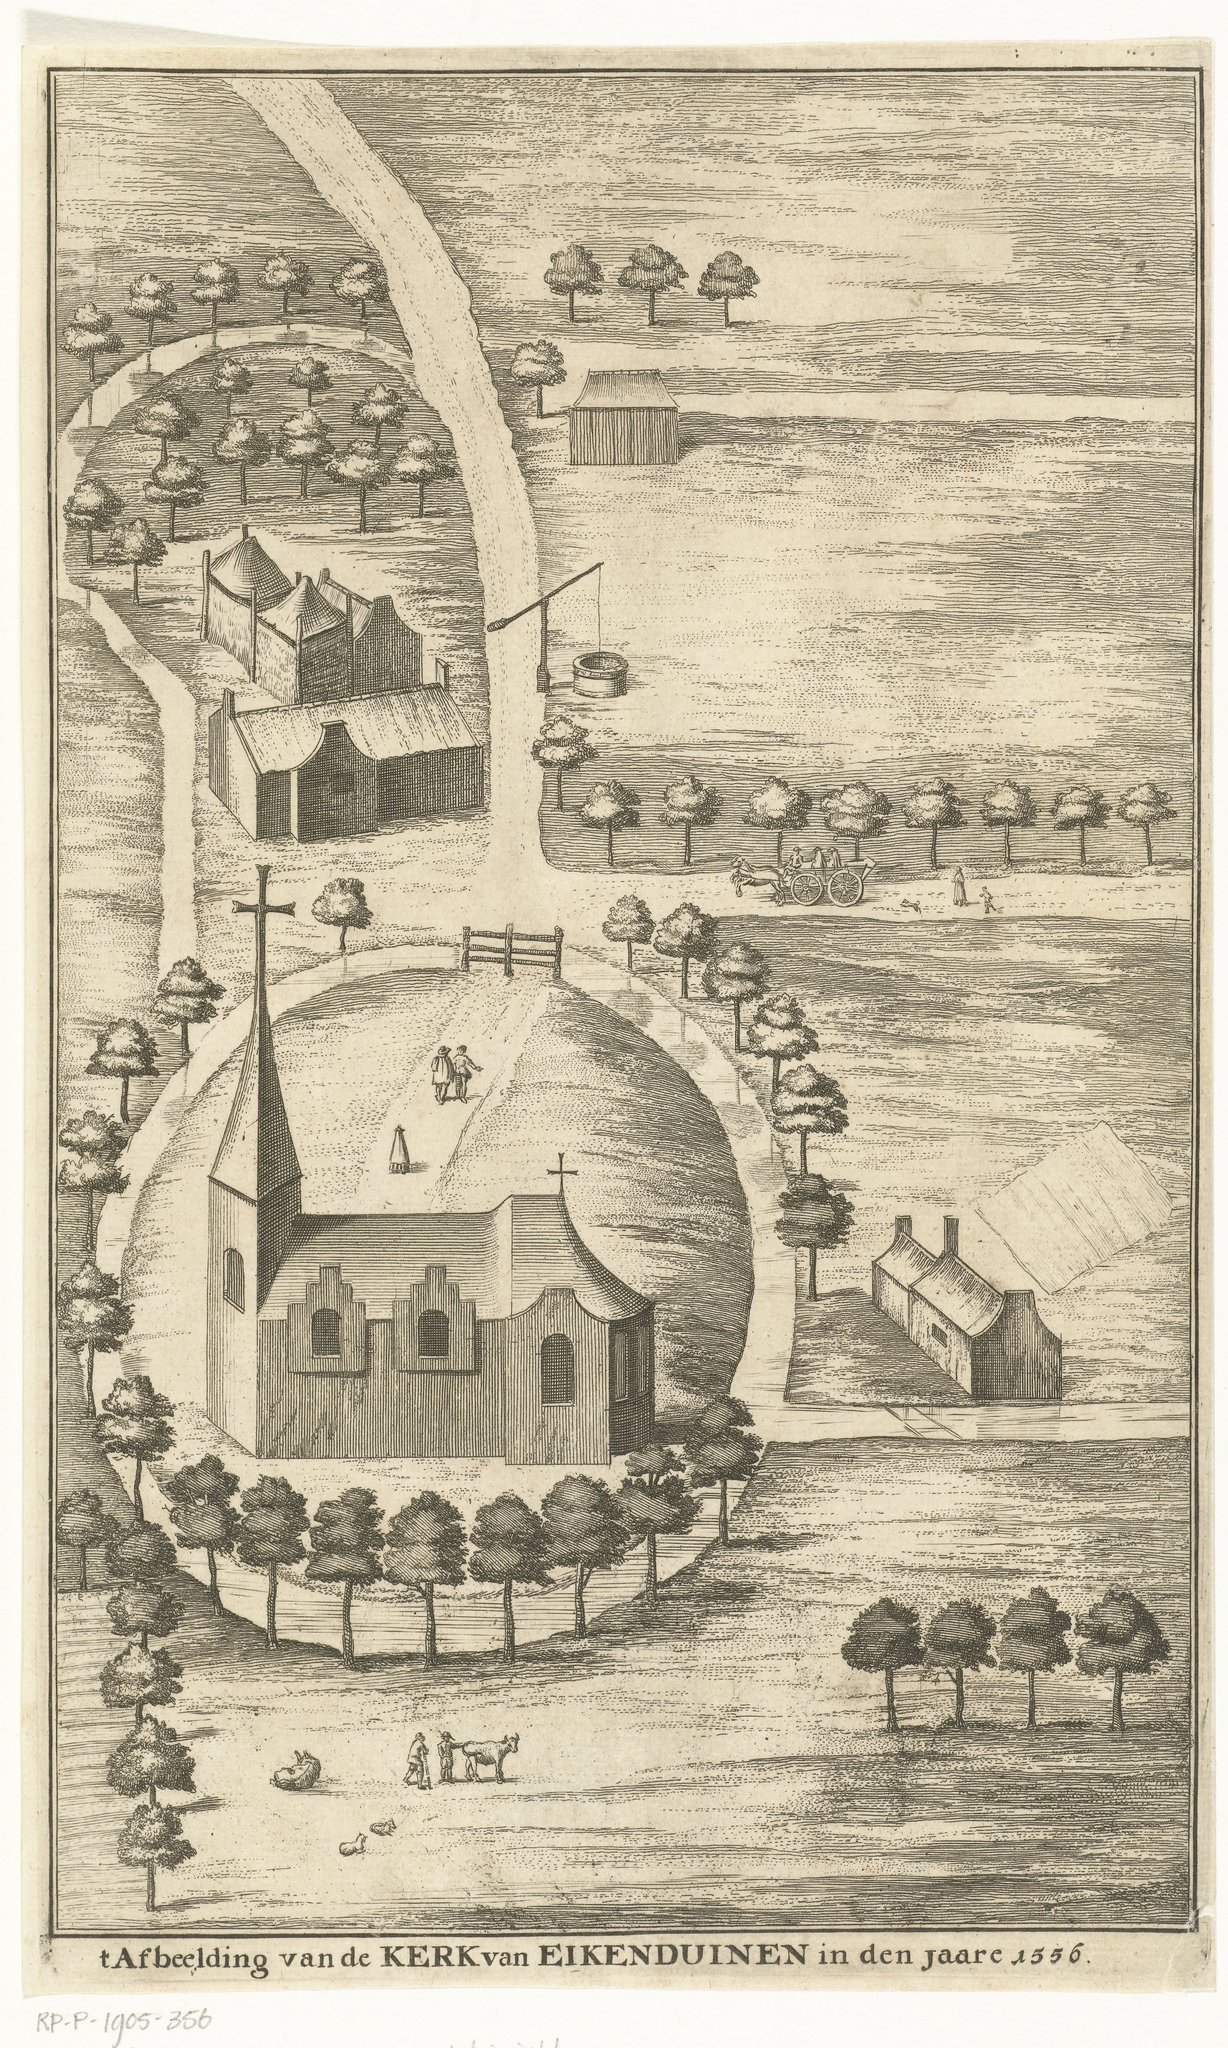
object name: book illustration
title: t Afbeelding van de kerk van Eikenduinen in den jaare 1556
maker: Anonymous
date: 1730-1736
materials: paper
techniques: engraving, etching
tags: church (exterior), bird's eye view ~ representation of building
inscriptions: collector's mark: Lugt 2228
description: Gezicht op de kerk van Eik en Duinen, een voormalig gehucht gelegen in de duinen tussen Loosduinen en Den Haag, in vogelvluchtperspectief in het jaar 1556. De kerk werd in 1580 gesloopt.